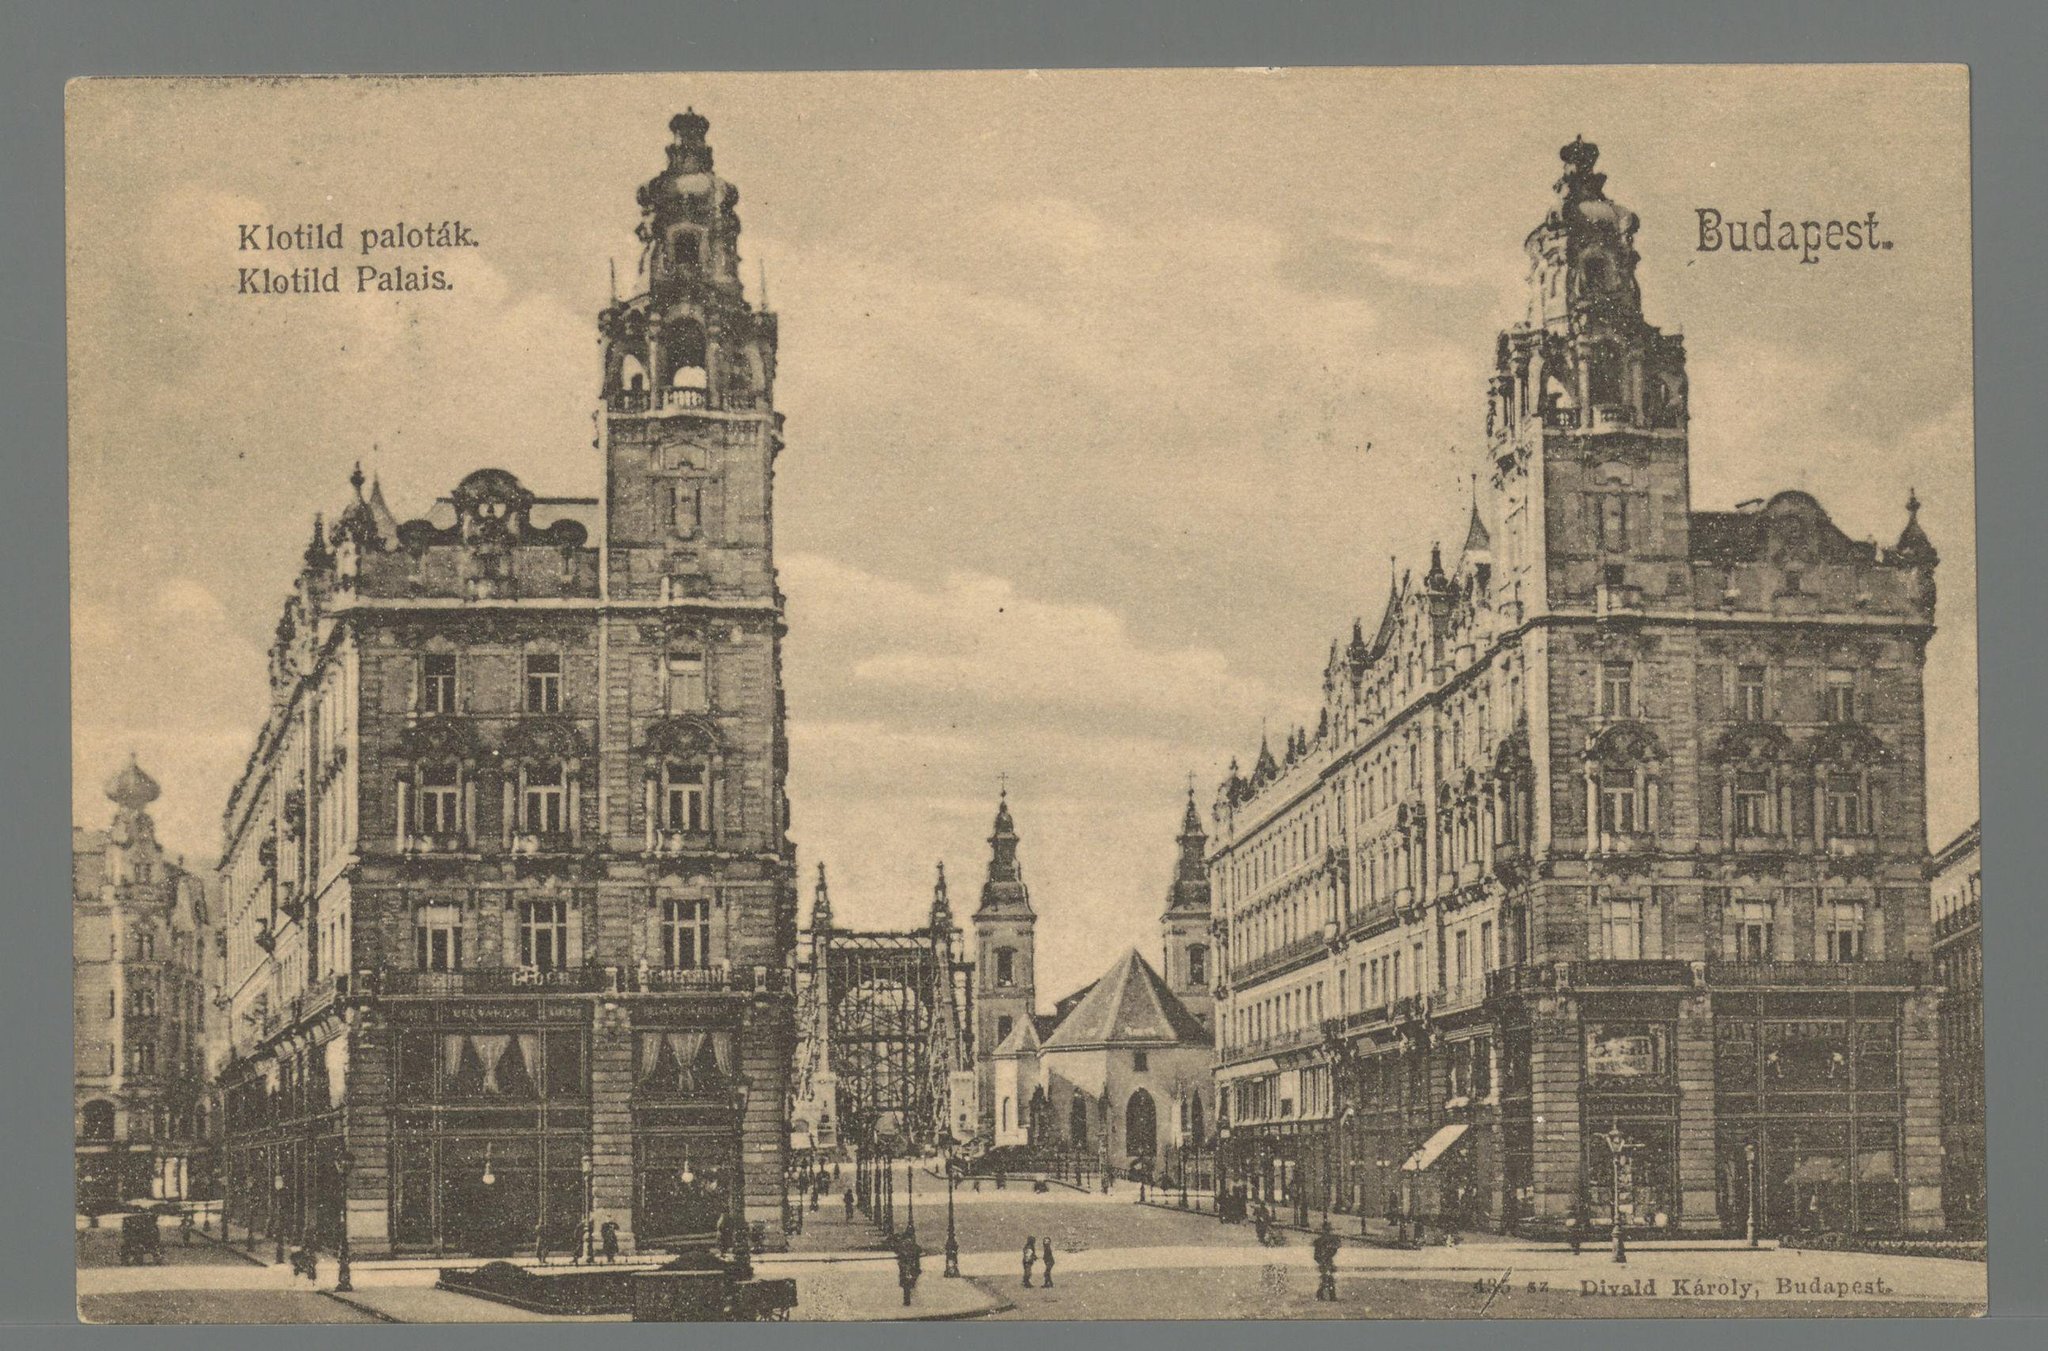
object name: photomechanical print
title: Klotild paloták / Klotild Palais. Budapest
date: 1890-1903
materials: cardboard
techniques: photograph, writing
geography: budapest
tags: palace, bridge in city across river, canal, etc.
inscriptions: postage stamp